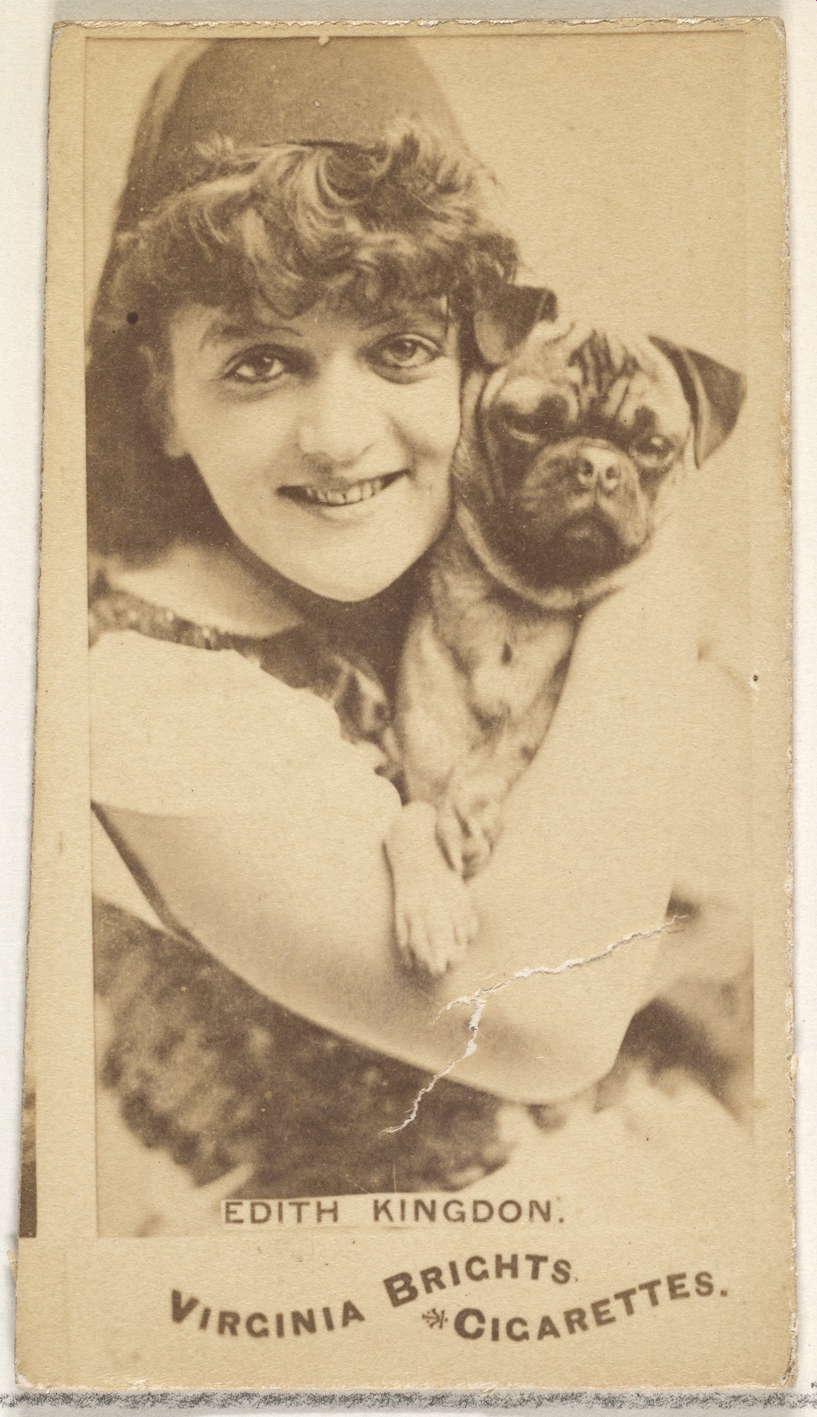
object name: photograph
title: Edith Kingdon, from the Actors and Actresses series (N45, Type 1) for Virginia Brights Cigarettes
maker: allen & ginter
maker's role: publisher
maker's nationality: american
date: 1888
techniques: albumen silver print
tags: portraits,women,dogs,actresses